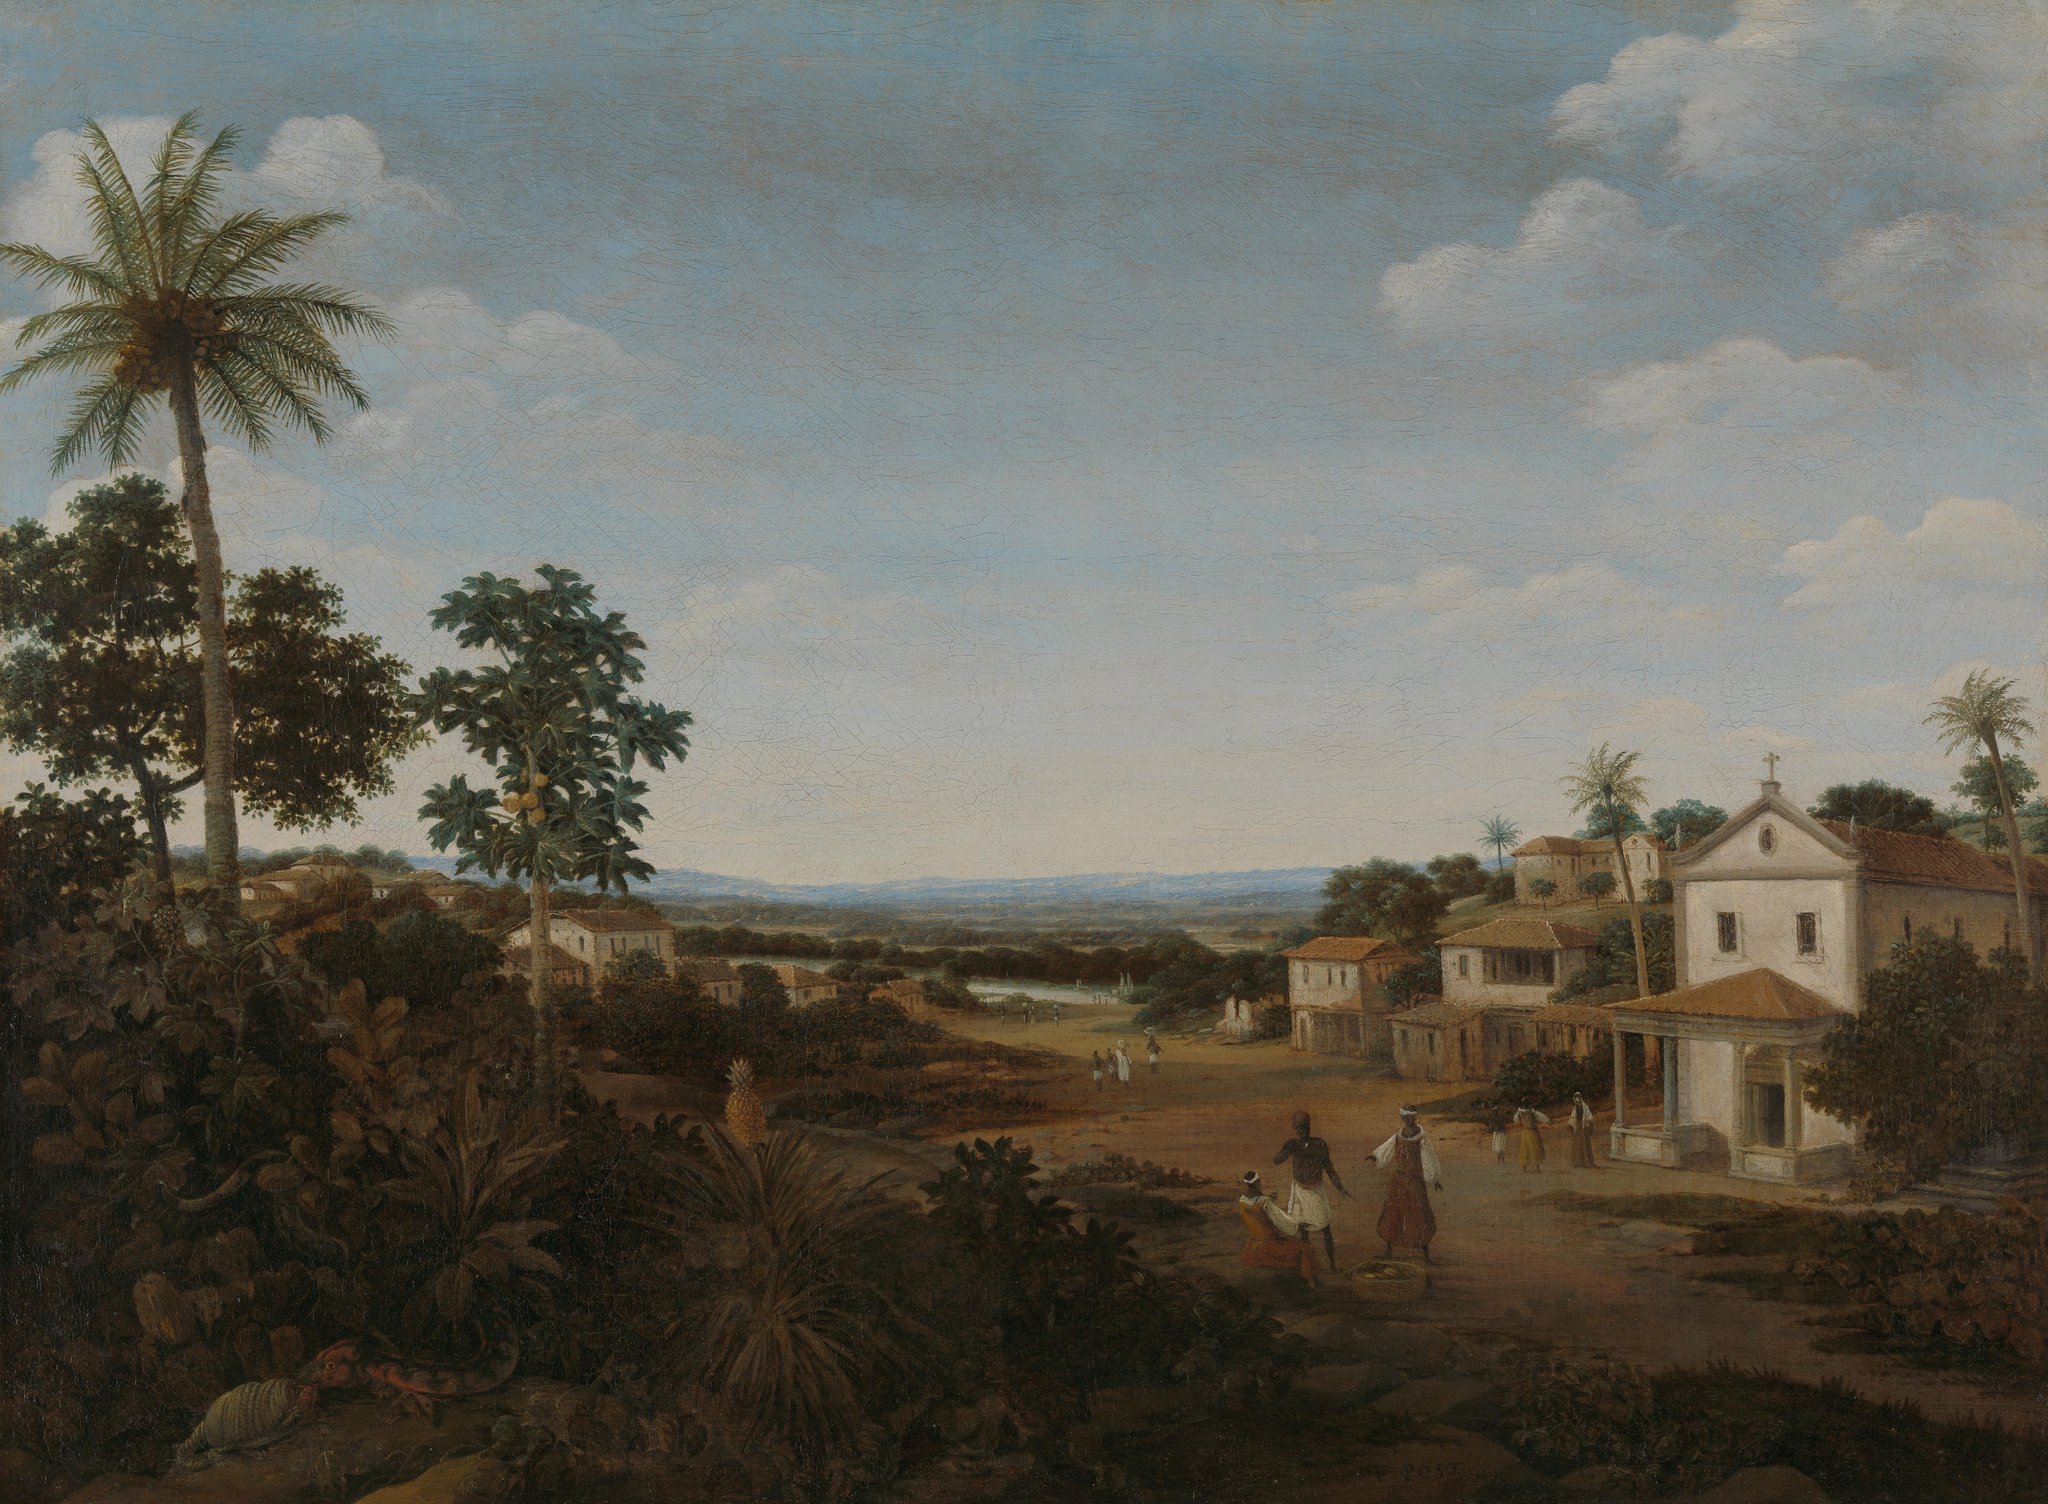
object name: painting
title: Landscape in Brazil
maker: frans jansz post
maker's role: painter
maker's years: 1612-1680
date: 1665-1669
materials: canvas, oil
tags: landscapes in tropical and sub-tropical regions, brasil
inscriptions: signature: ‘F. Post’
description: After a stay in Brazil, Frans Post returned to his native Haarlem. He would spend the rest of his life there producing paintings based on sketches of the landscape and animals he had made in South America. In most of his work the animals appear to live together in harmony, but not in this canvas: a boa constrictor in the left foreground is devouring a six-banded armadillo.